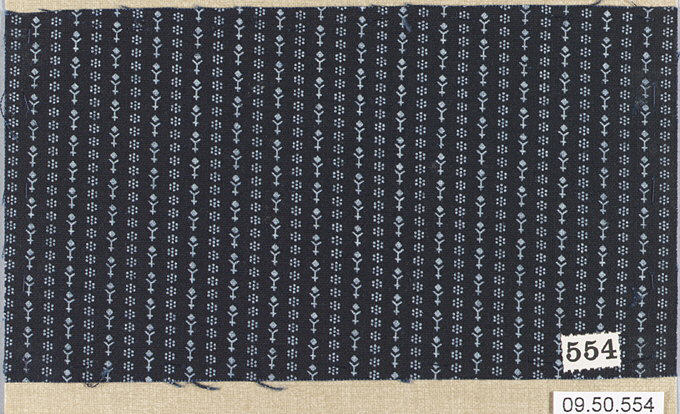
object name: piece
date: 1801-1900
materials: cotton